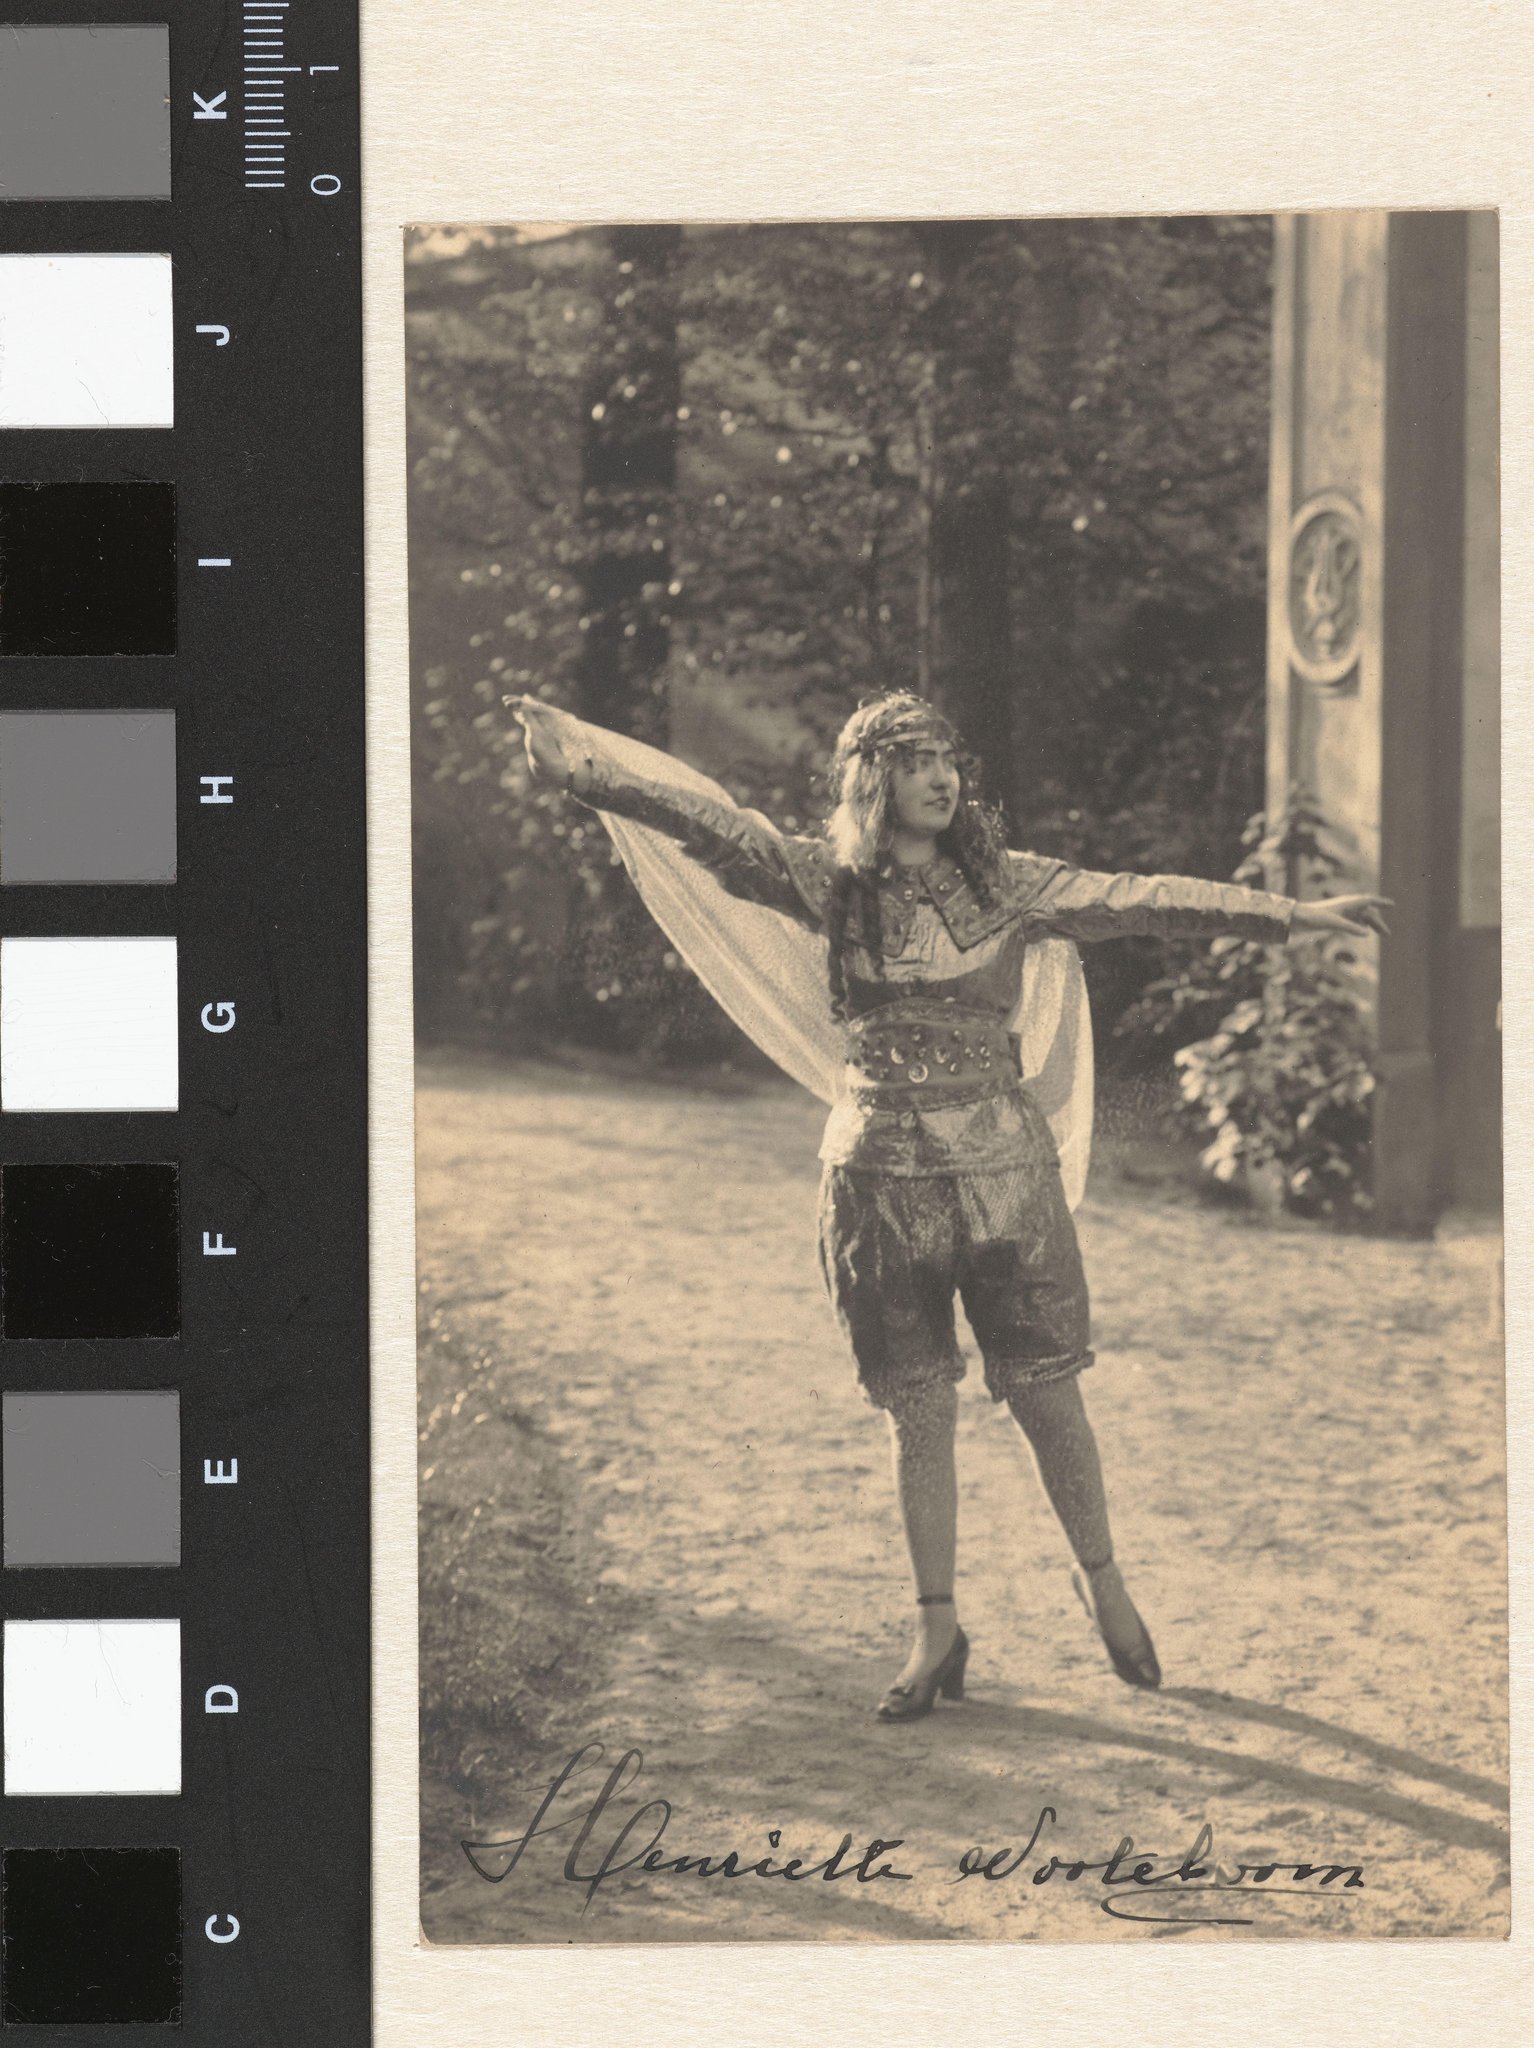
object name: ansichtkaart, prentbriefkaart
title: Henriëtte Nooteboom in een danspose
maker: adrianus van beurden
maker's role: fotograaf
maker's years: 1843-1915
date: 1900-1940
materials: paper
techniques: gelatin silver print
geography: tilburg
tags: woman dancing alone, historical persons, netherlands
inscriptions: name: ‘Henriëtte Nooteboom’